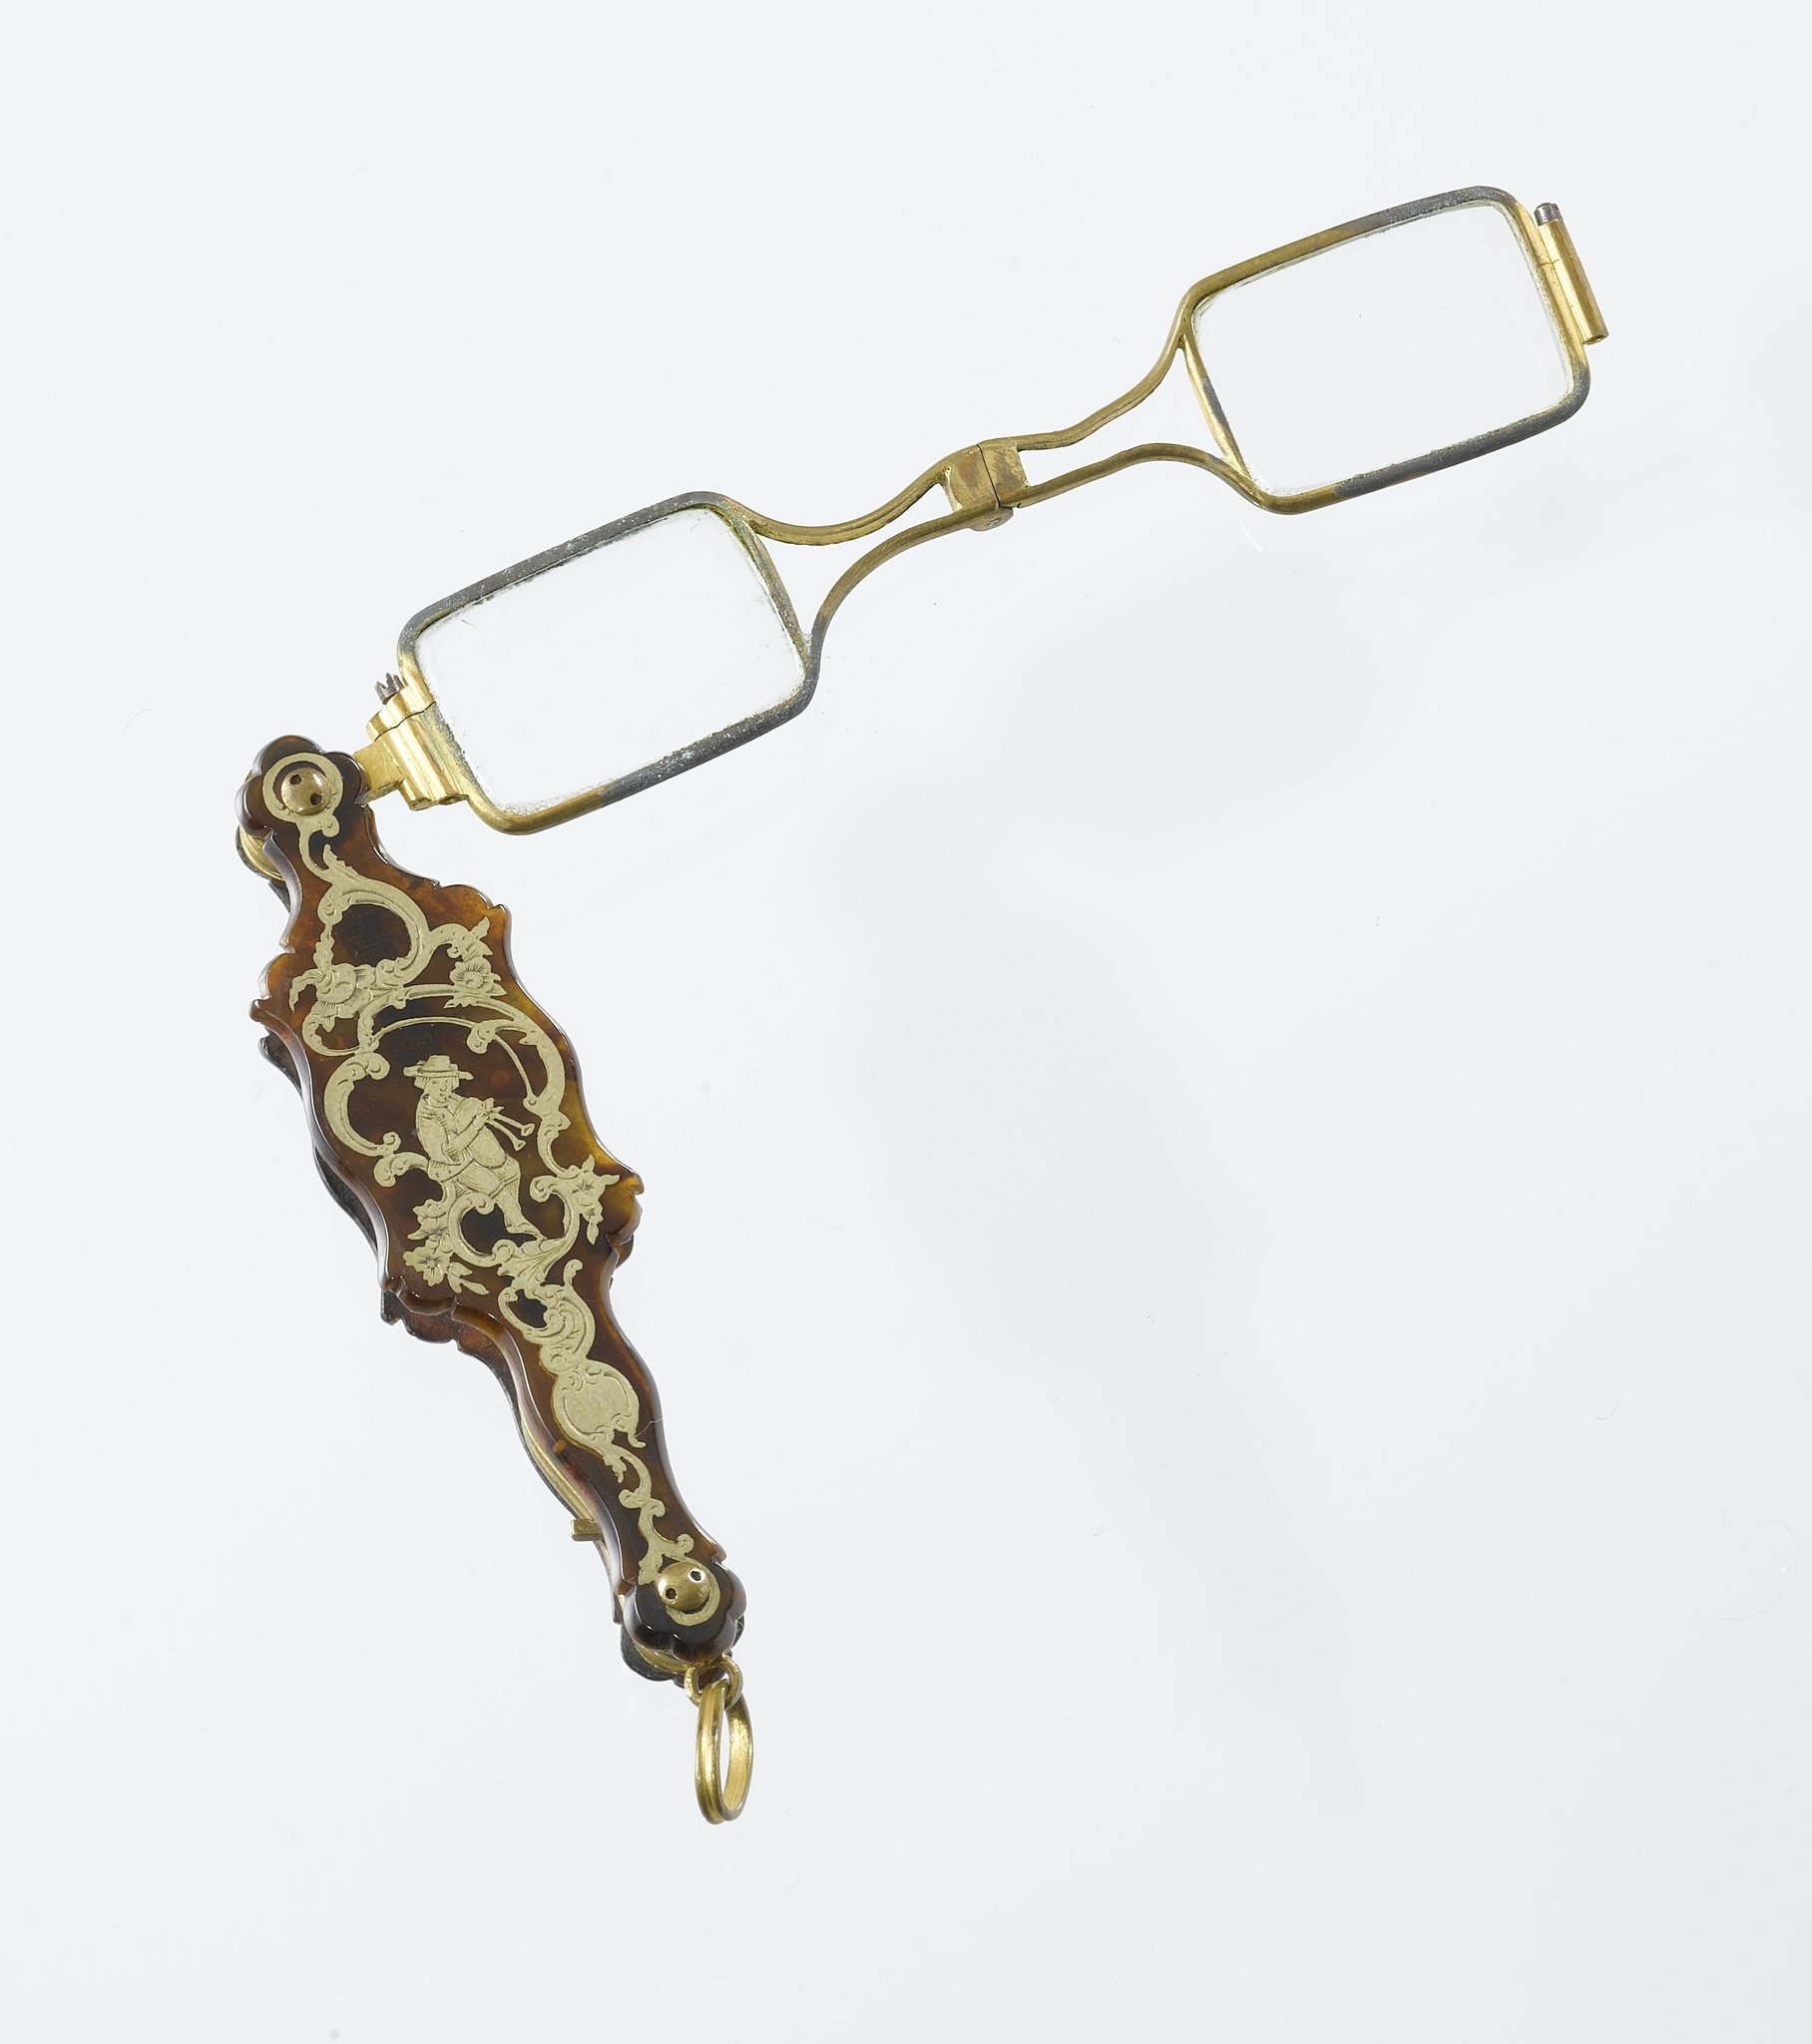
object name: spectacle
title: Scharnierlorgnet met montuur van koper in steel van schildpad, ingelegd met rocailles en fluitspelers van verguld zilver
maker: Anonymous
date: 1845-1865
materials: glass, silver, shell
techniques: cutting, forging, grinding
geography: netherlands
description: Scharnierlorgnet met montuur van koper in steel van schildpad, ingelegd met rocailles en fluitspelers van verguld zilver.